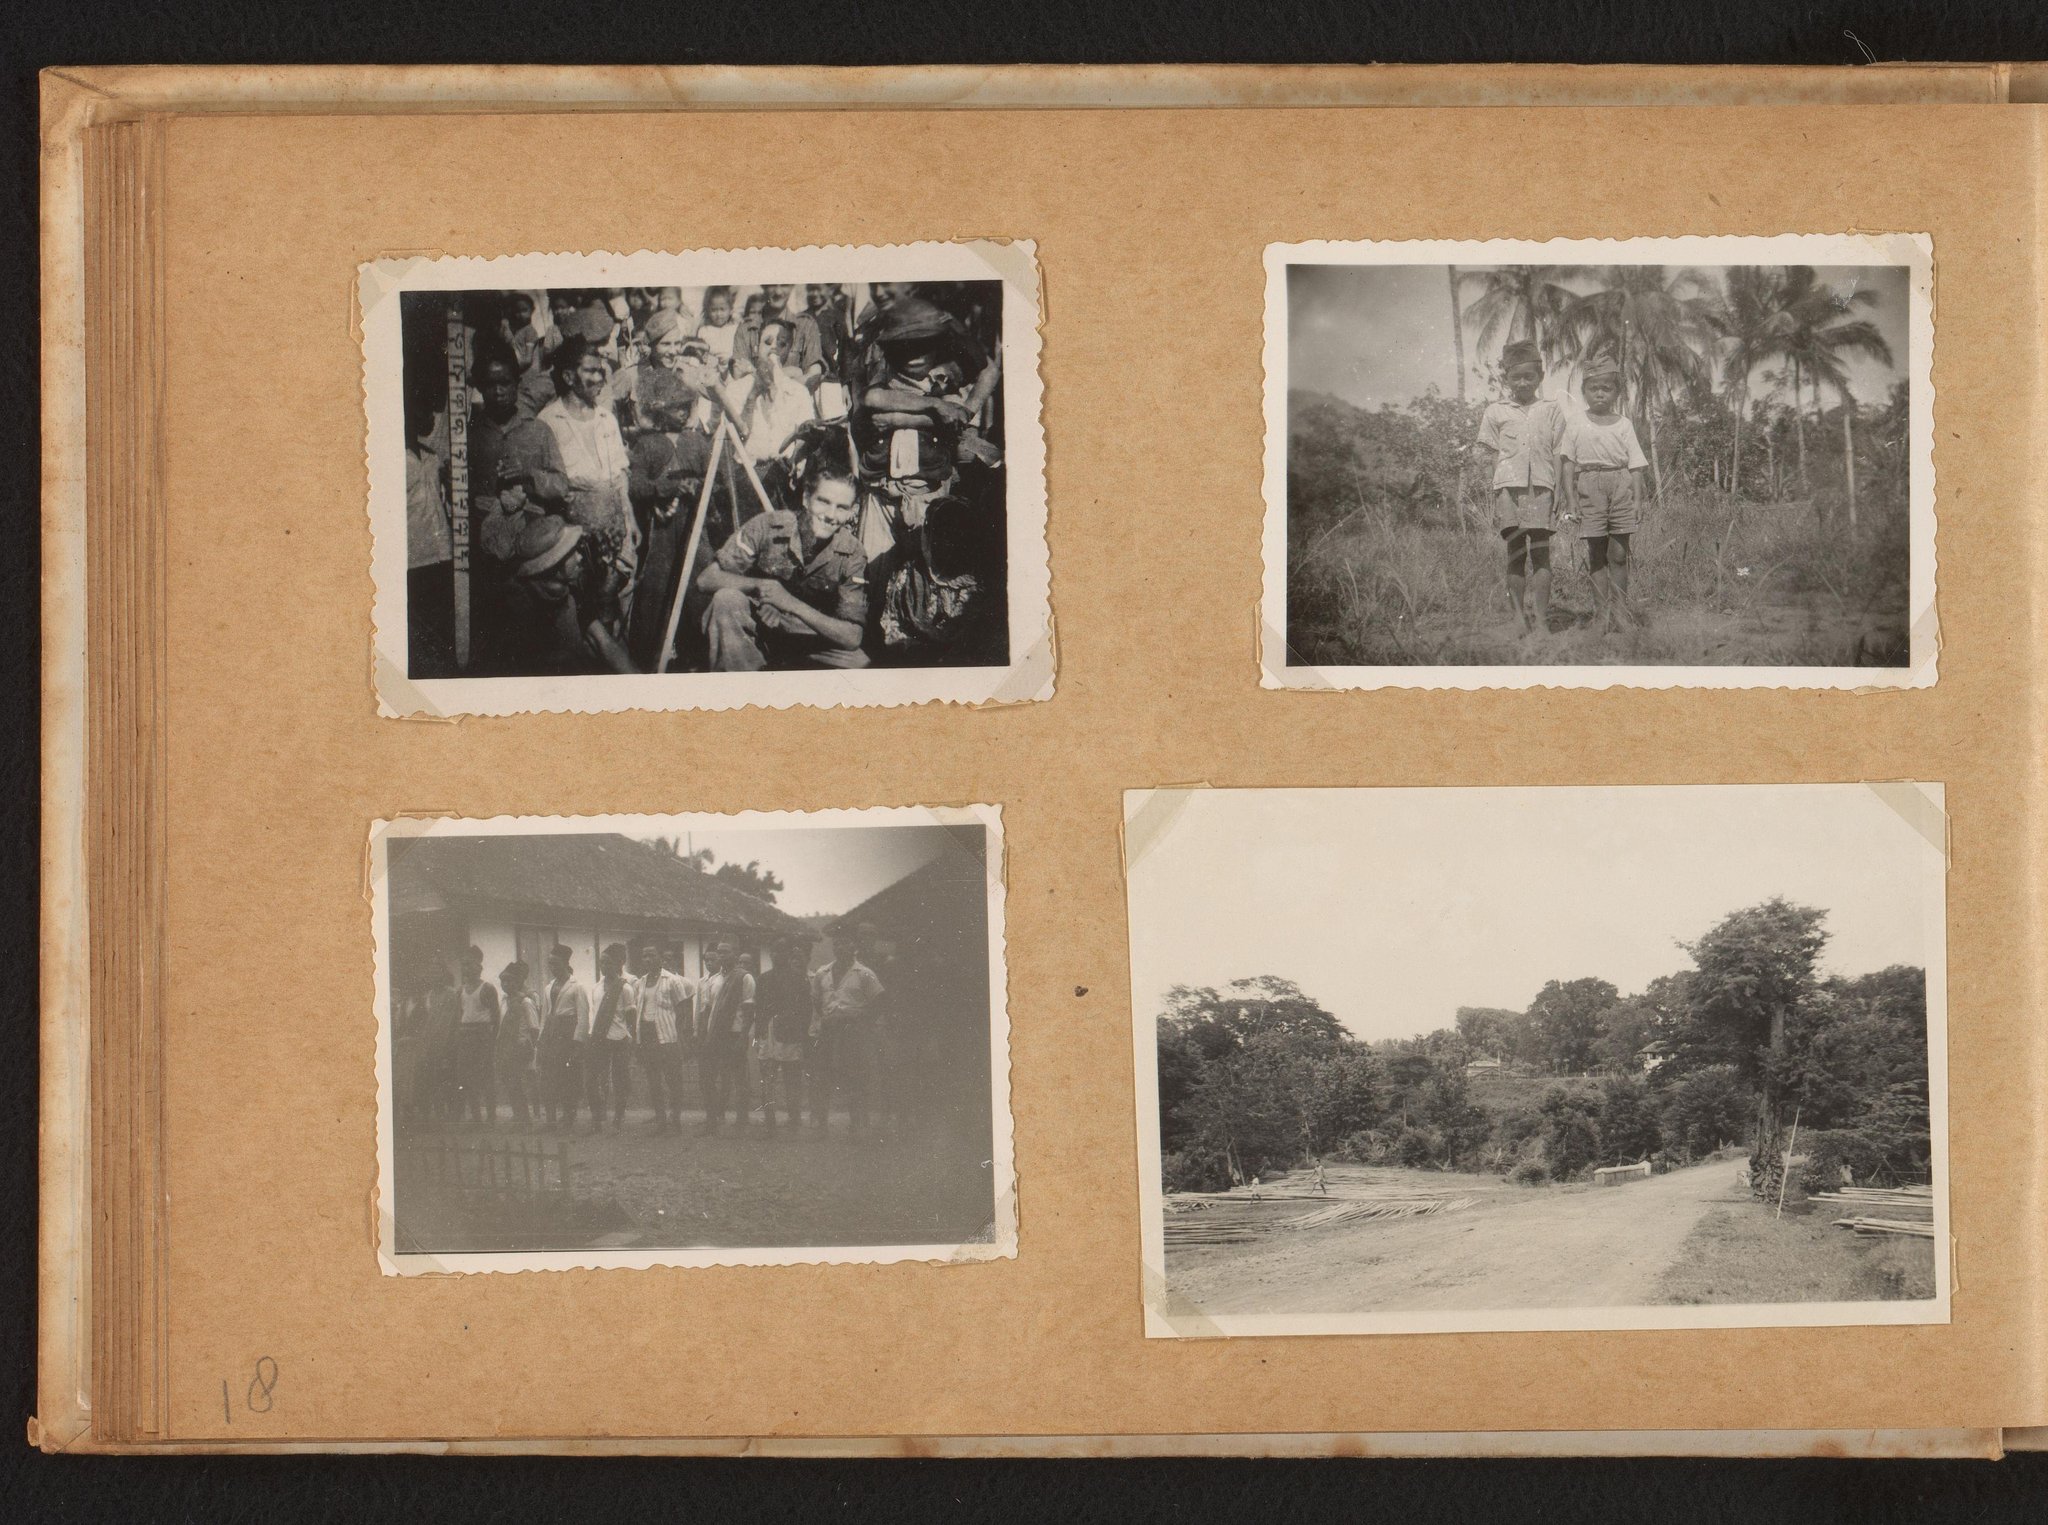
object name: photograph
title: Lokale bevolking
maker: Anonymous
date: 1948-1949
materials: cardboard, photographic support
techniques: gelatin silver print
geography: dutch east indies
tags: village, dutch east indies, the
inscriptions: inscription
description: Albumblad met vier foto's van de lokale bevolking en een landschap. Onderdeel van het fotoalbum 'Ter herinnering aan mijn diensttijd overzee' 1948-1949.